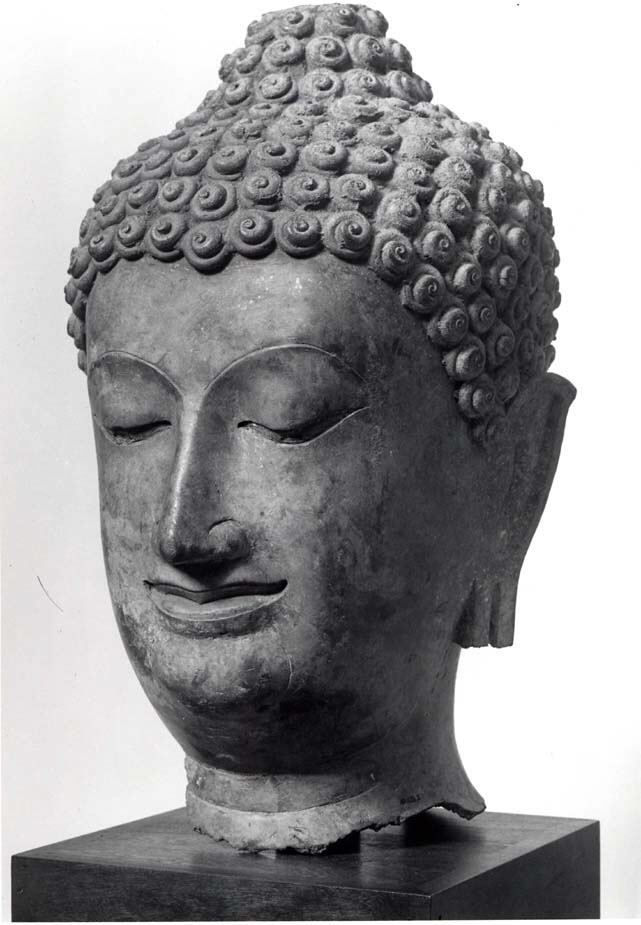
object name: head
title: Head of Buddha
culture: thai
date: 1401-1500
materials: bronze, patina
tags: heads,buddhism,buddha